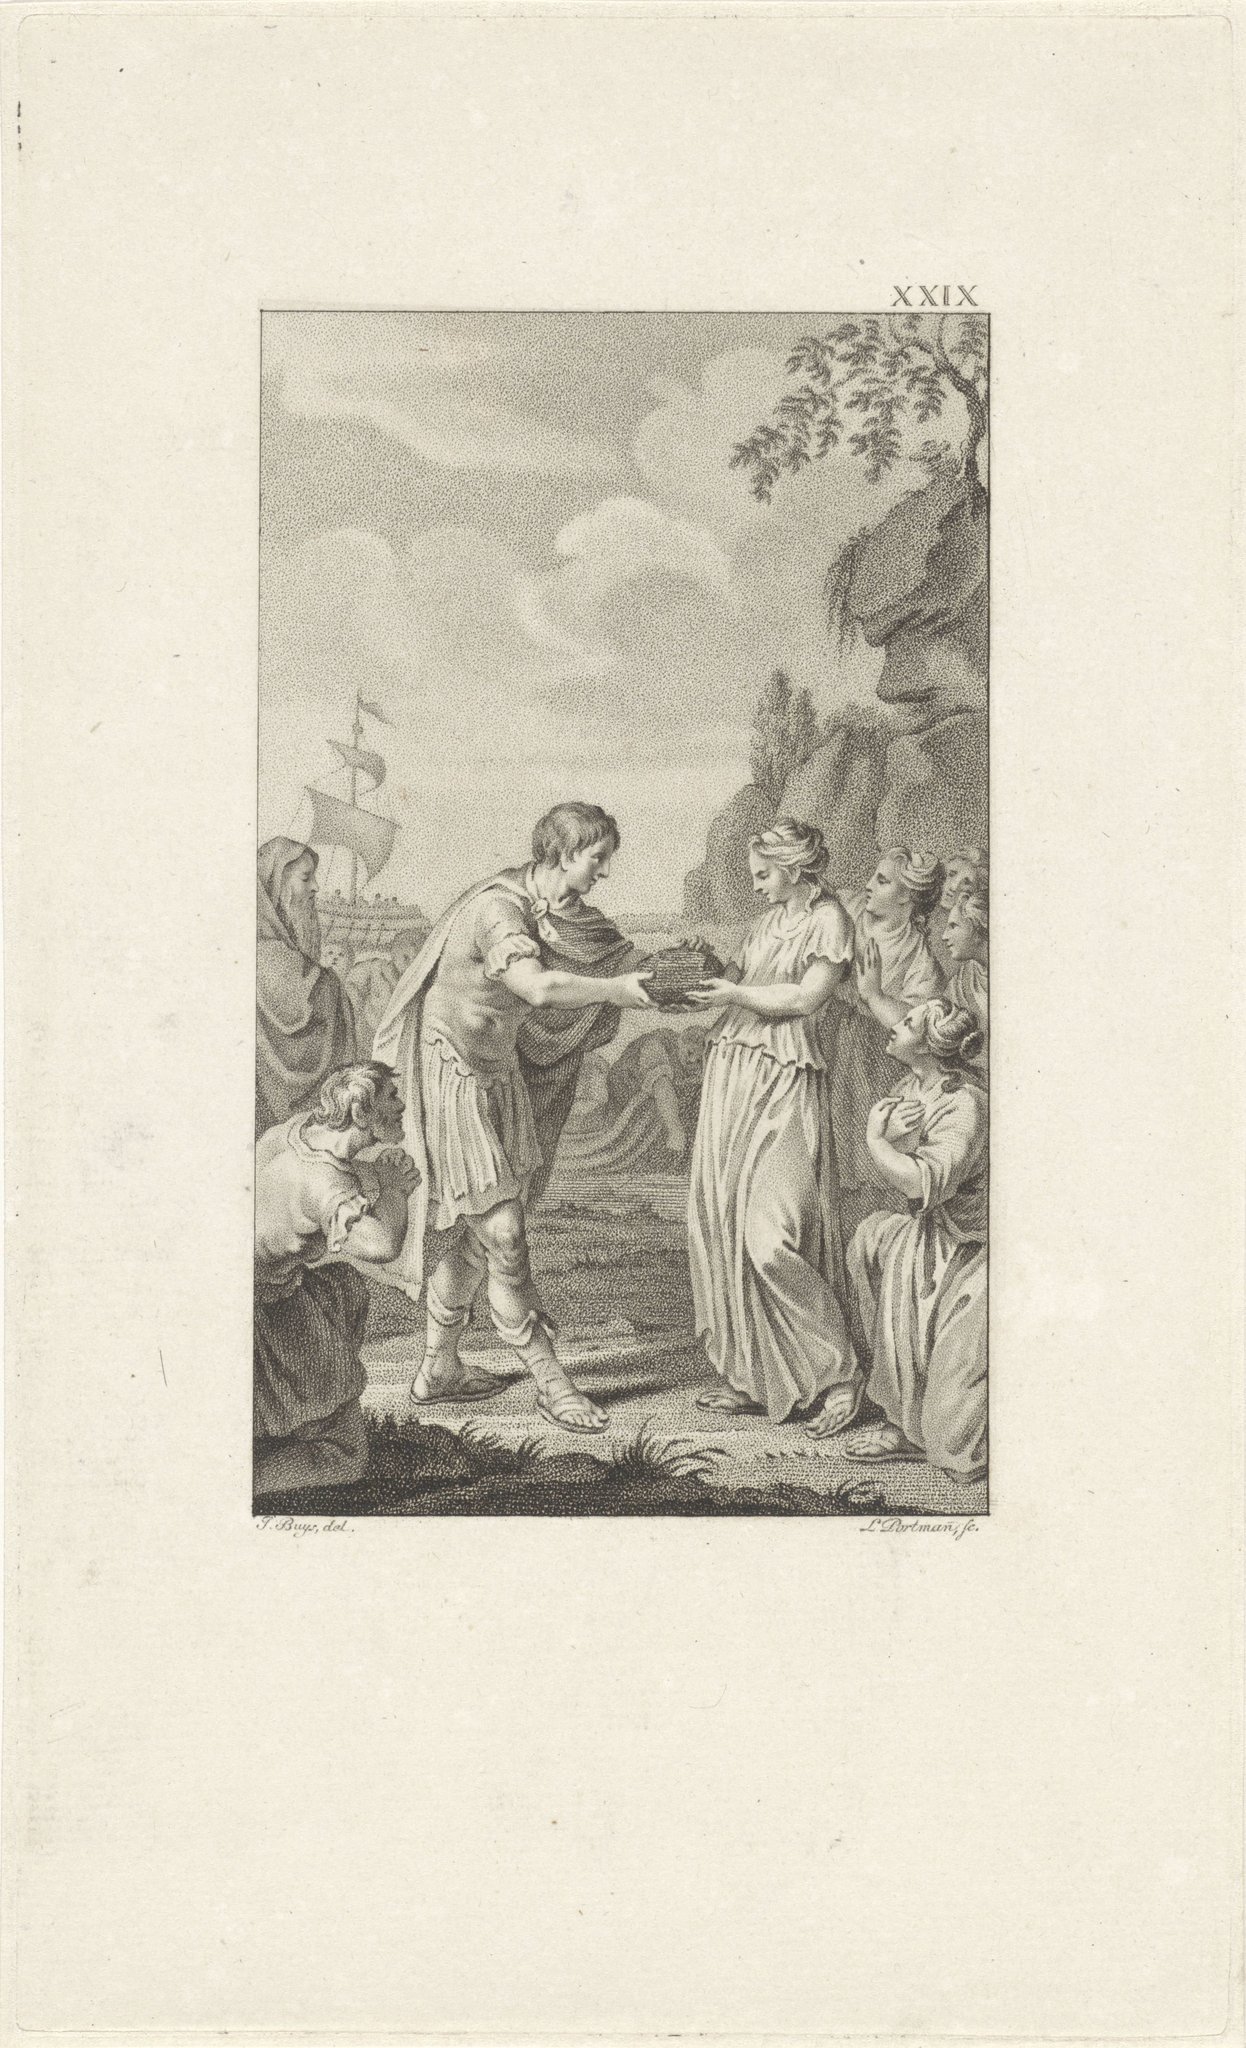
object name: print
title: Aankomst van het beeld van Cybele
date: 1796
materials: paper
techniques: stippled etching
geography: amsterdam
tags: when the statue of cybele is brought to rome, p. cornelius scipio nasica is chosen to meet the goddess in the harbour of ostia, and ordered to bring her to rome with the greatest pomp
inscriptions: collector's mark: Lugt 2228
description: Publius Cornelius Scipio Nasica ontvangt het beeld van Cybele, de godin van de aarde, in de haven van Ostia. Hij moet het zo spoedig mogelijk naar Rome brengen.